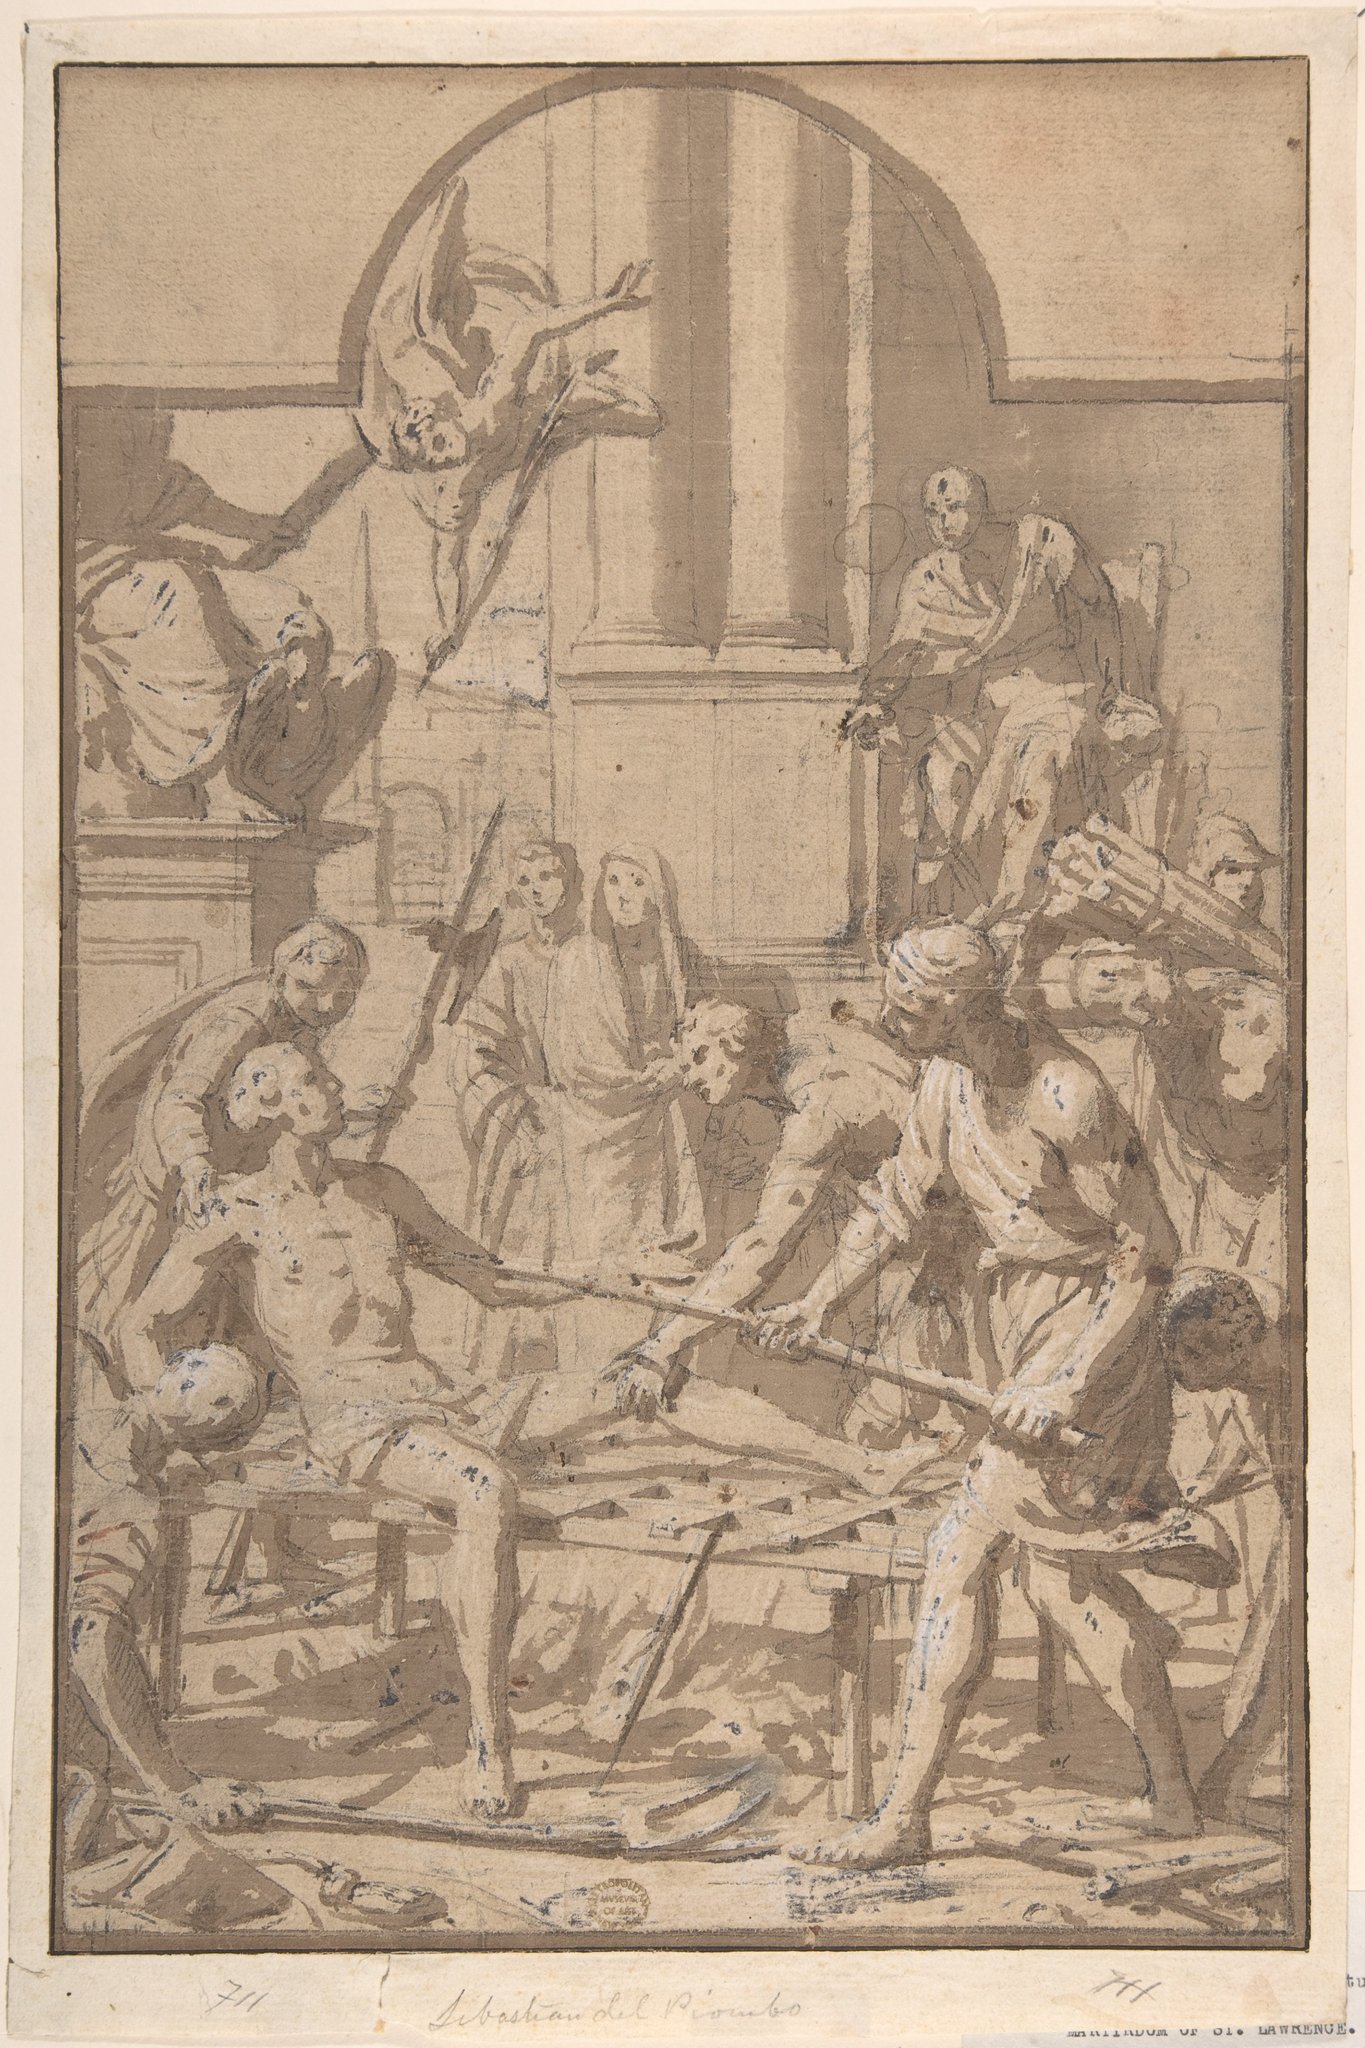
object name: drawing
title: Martyrdom of Saint Lawrence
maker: anonymous, italian, roman-bolognese, 17th century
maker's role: artist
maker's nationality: italian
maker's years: 1600-1700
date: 1601-1700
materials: chalk, gouache, paper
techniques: brush, heightening, wash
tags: suffering,men,women,saint lawrence